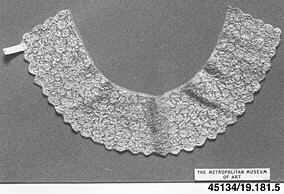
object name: collar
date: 1601-1700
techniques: lace